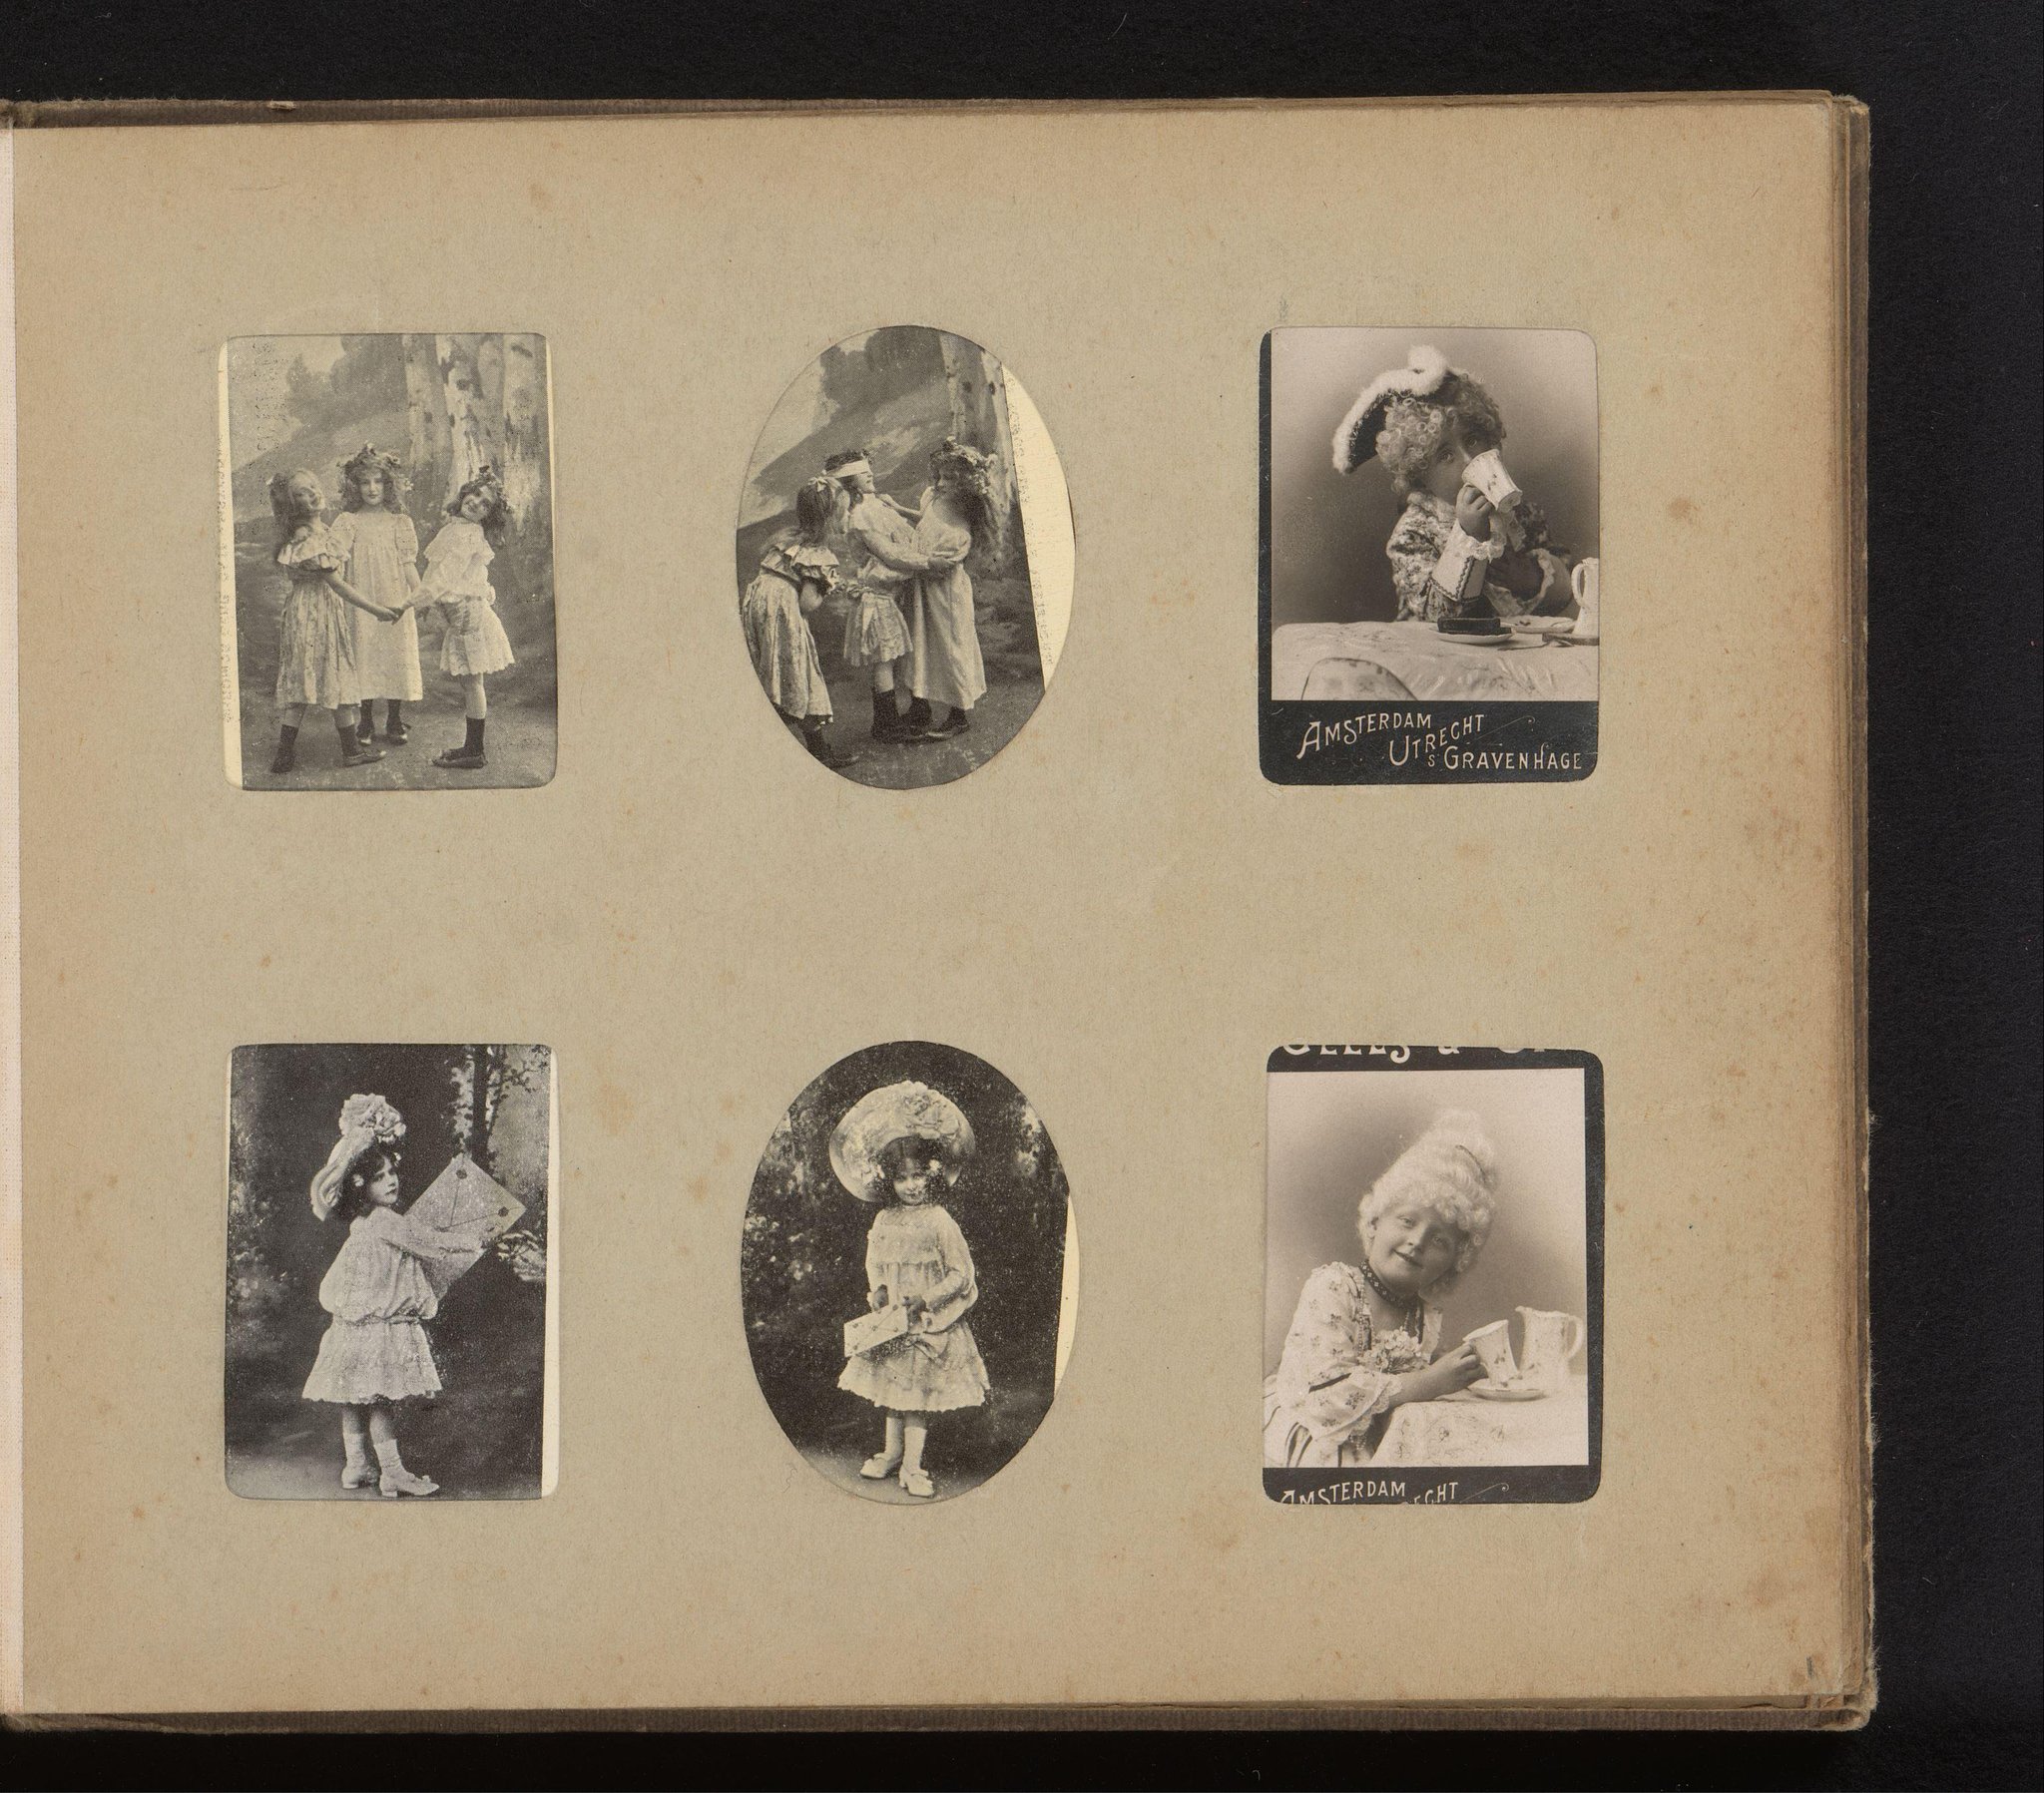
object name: photomechanical print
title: Kinderportretten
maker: Anonymous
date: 1890-1900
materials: cardboard, paper, photographic support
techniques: gelatin silver print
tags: clothes, costume, child (at home)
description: Zes portretten van kinderen, waaronder twee portretten van kinderen in kostuums. Deze pagina is deel van een album.